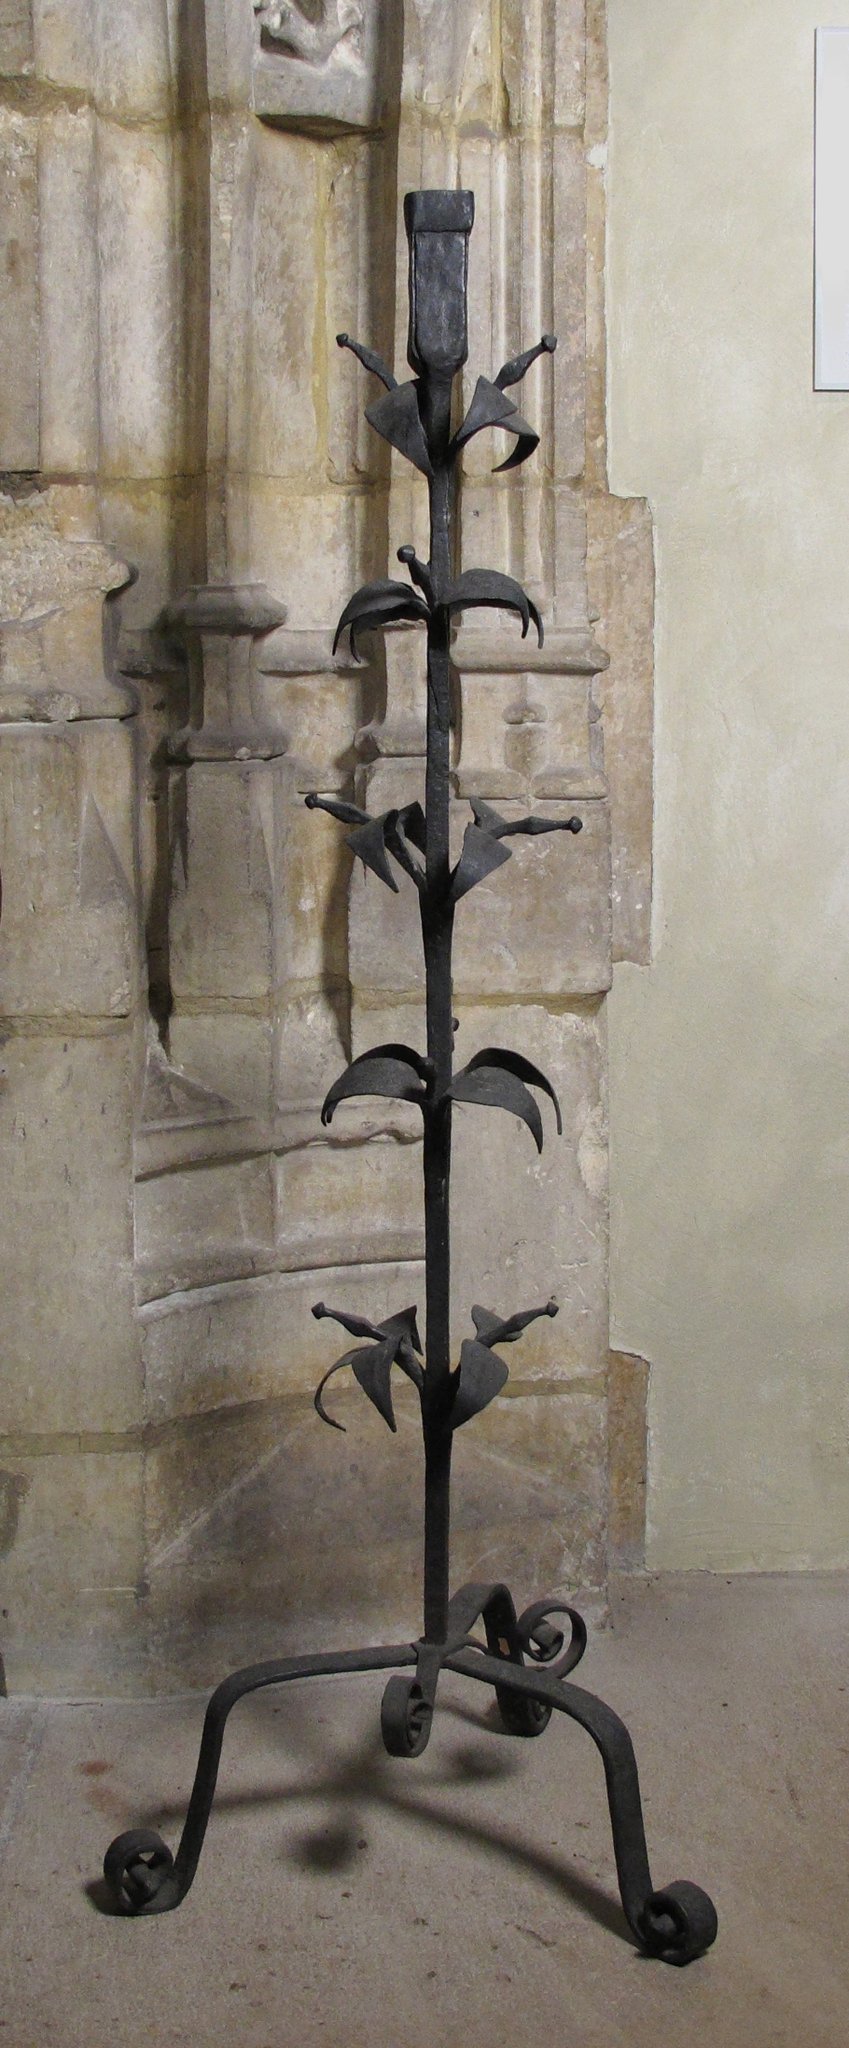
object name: candelabrum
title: Candelabra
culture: french or spanish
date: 1301-1500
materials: iron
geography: france or spain